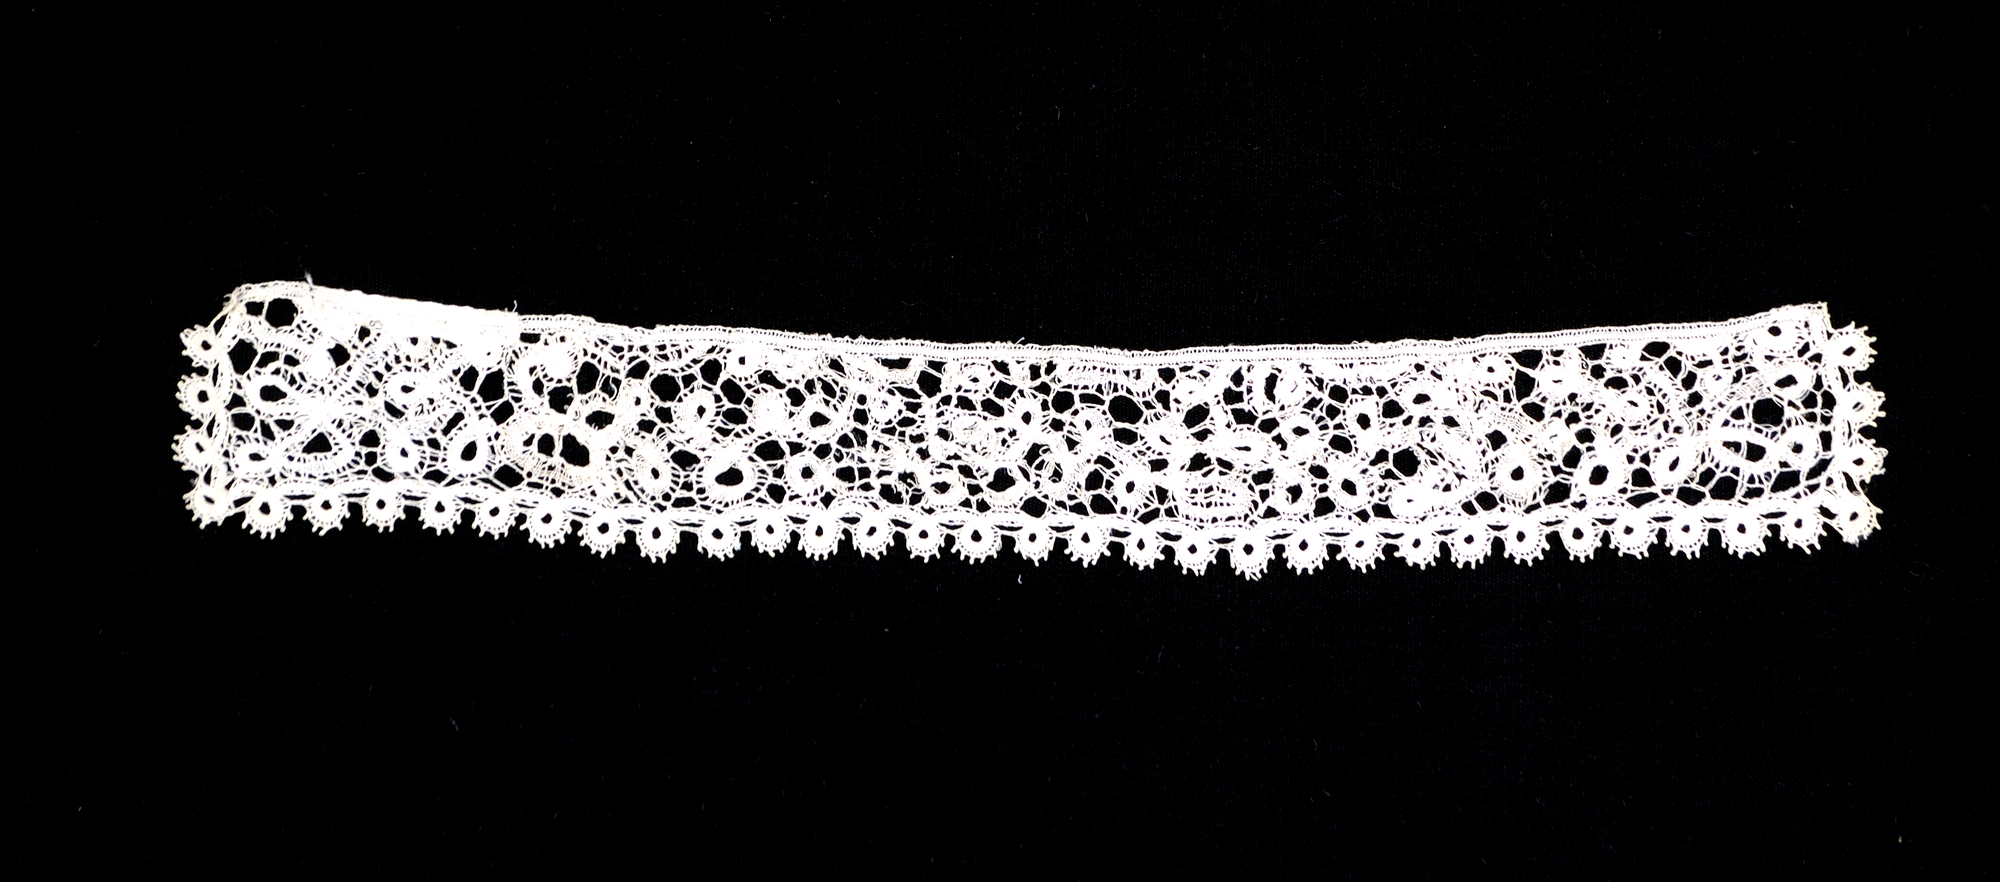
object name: cuff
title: Cuffs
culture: flemish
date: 1834-1866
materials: linen